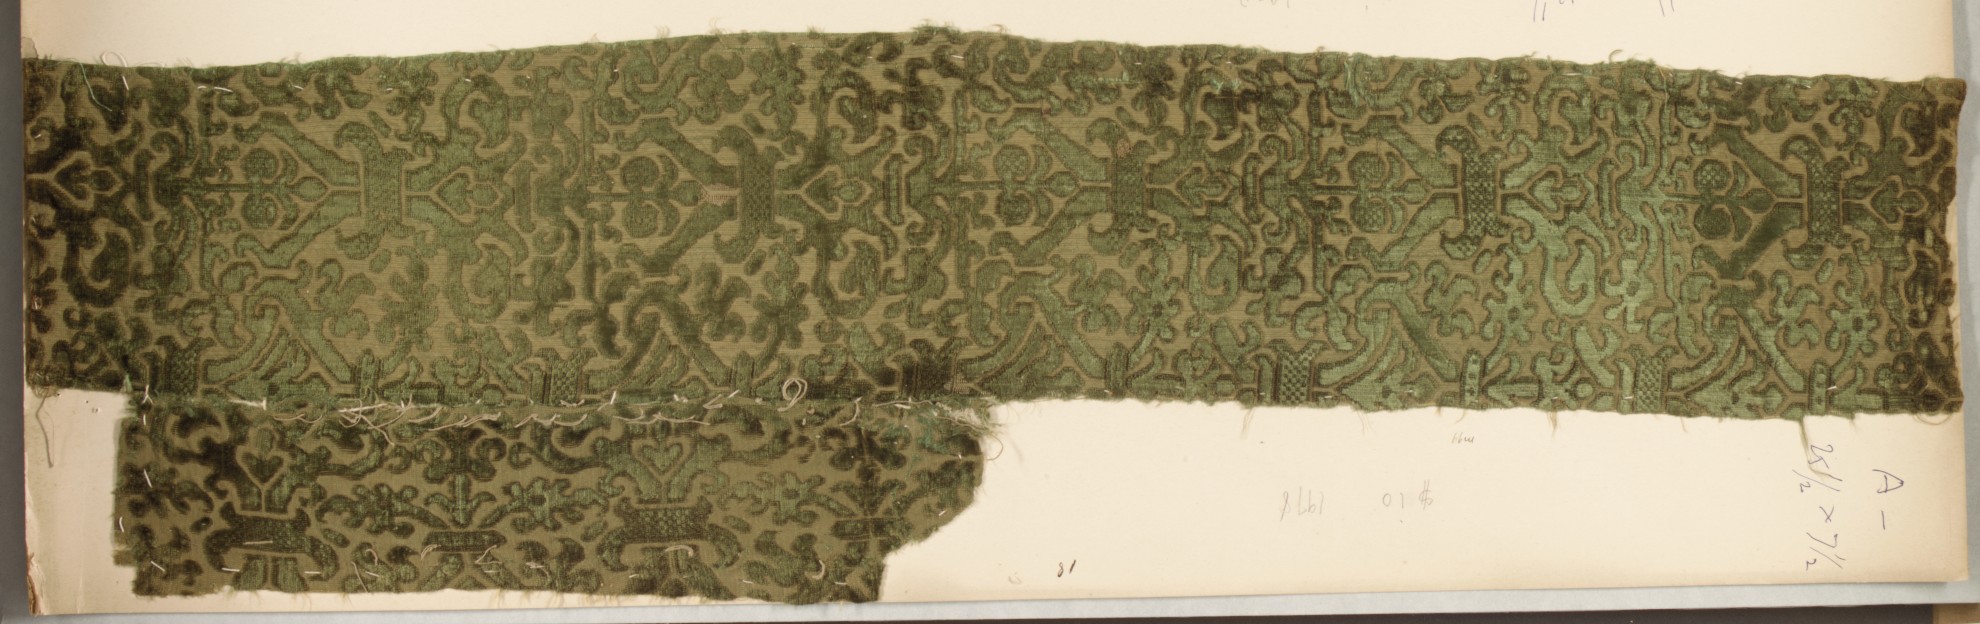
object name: fragment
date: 1567-1600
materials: silk